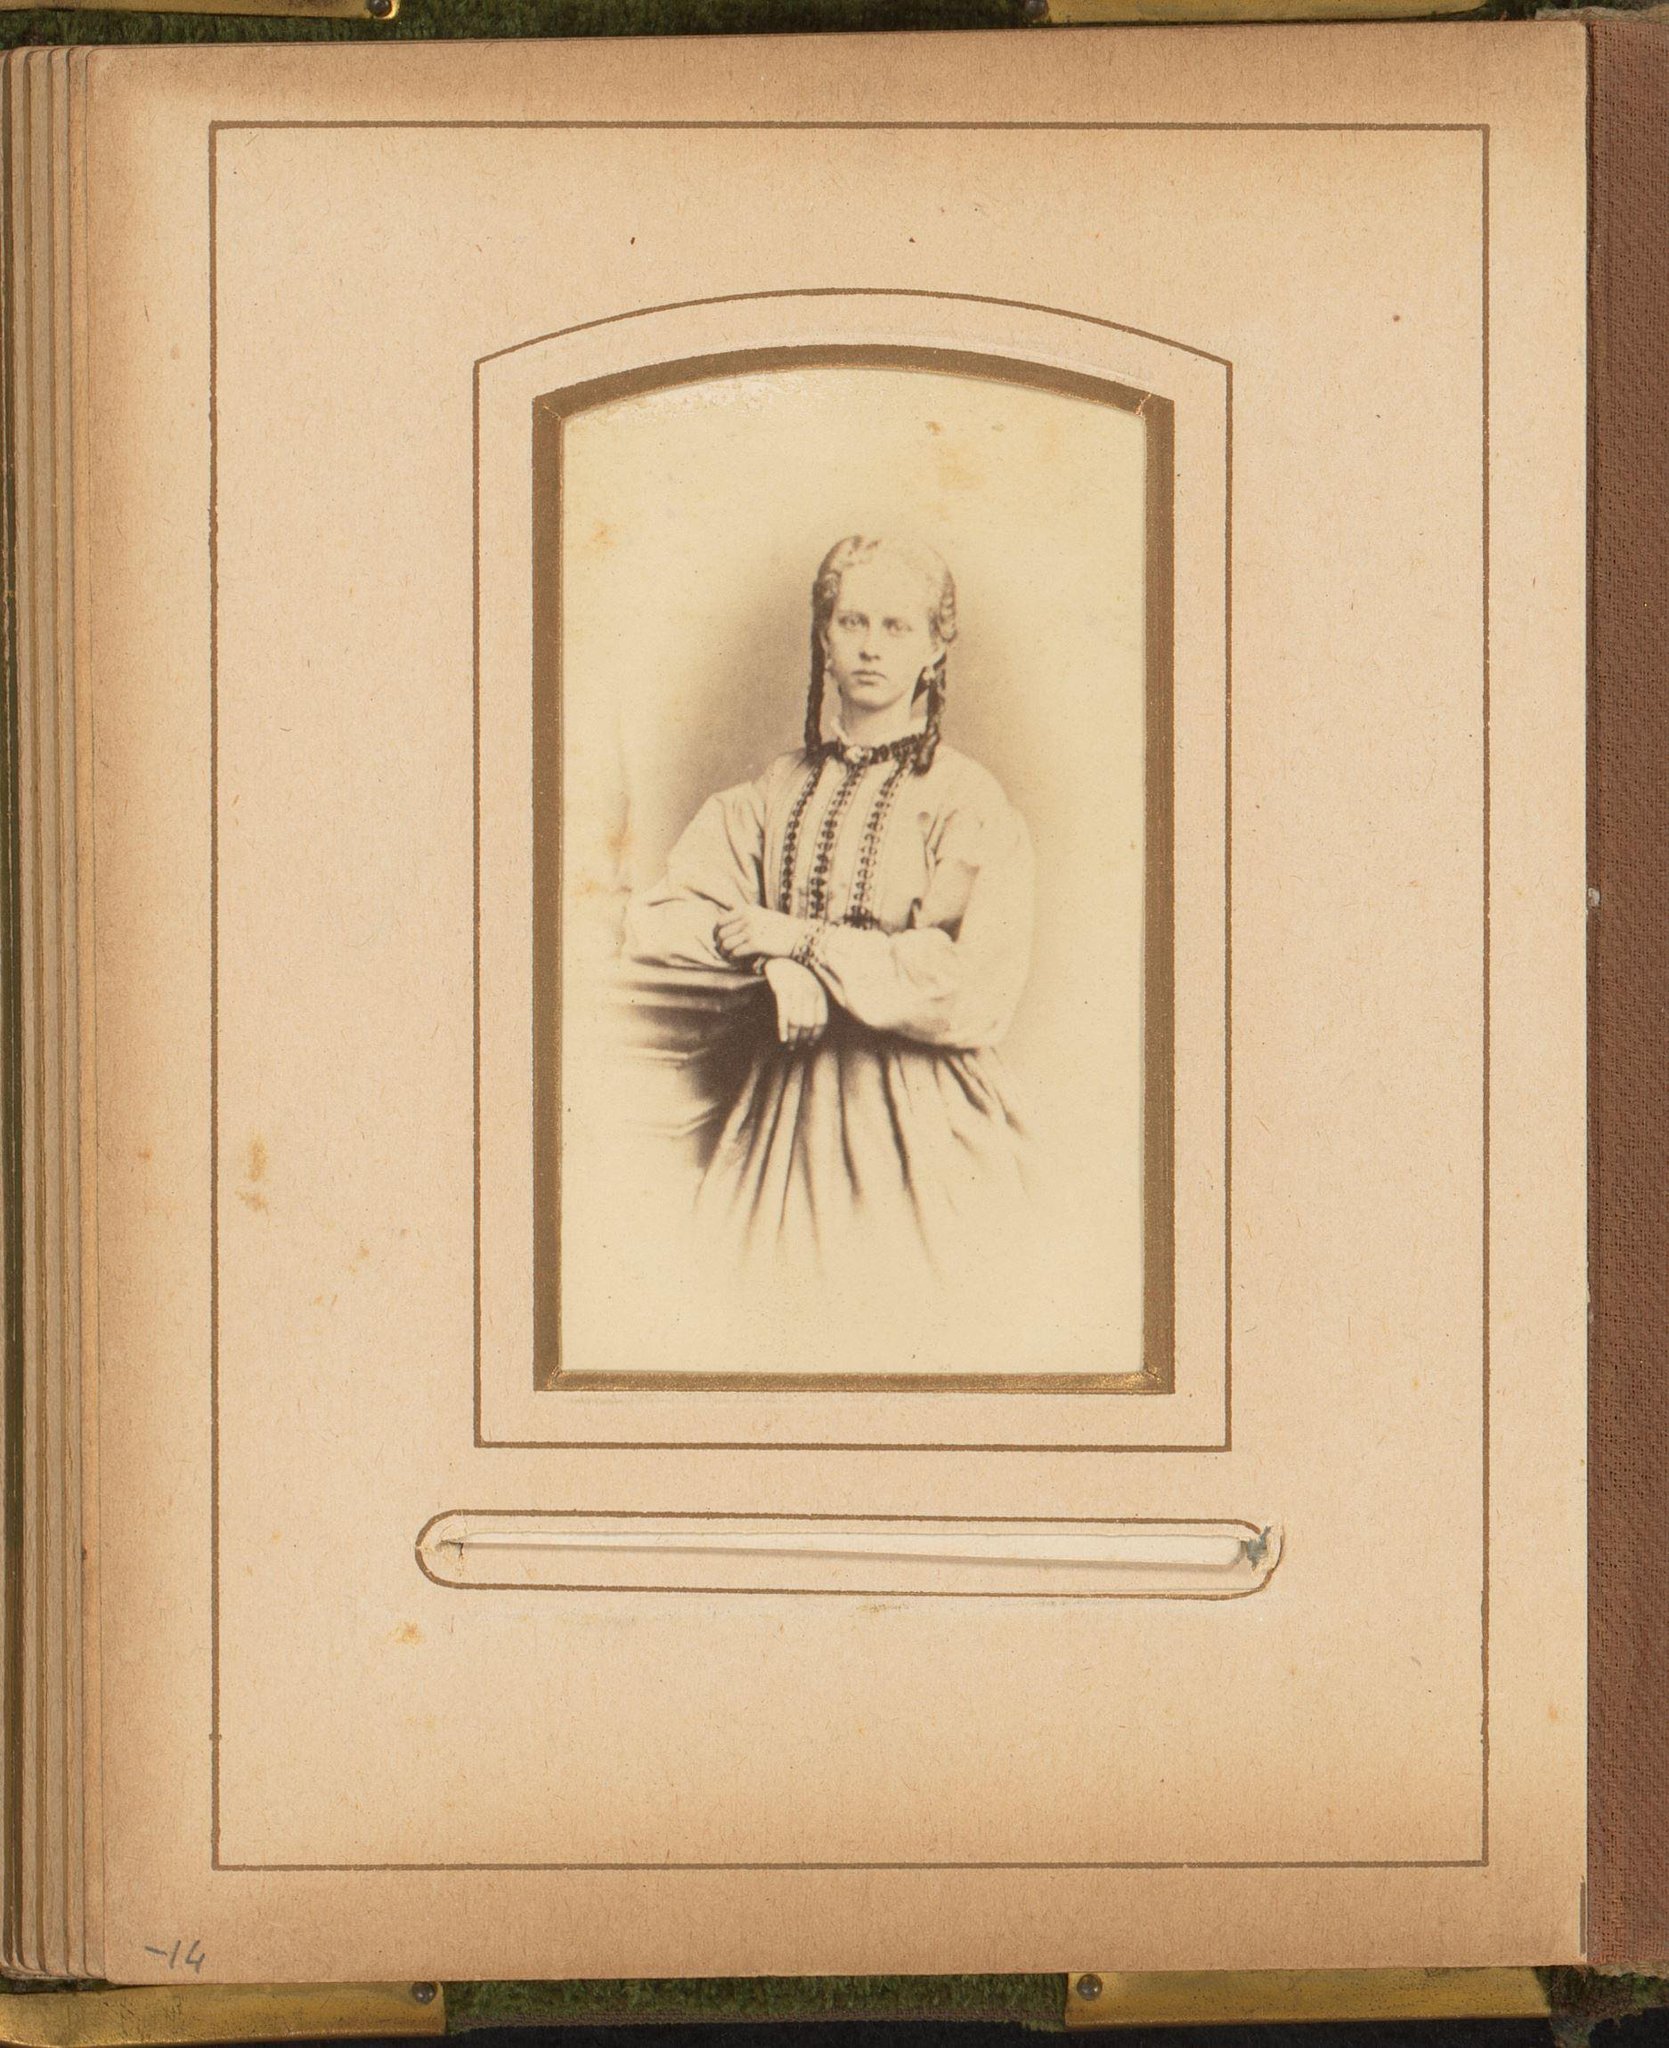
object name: photograph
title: Portret van een jonge vrouw, mogelijk lid van de familie Beucker Andreae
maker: Anonymous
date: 1854-1885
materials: cardboard, paper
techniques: albumen print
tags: adolescent, young woman, maiden, anonymous historical person portrayed